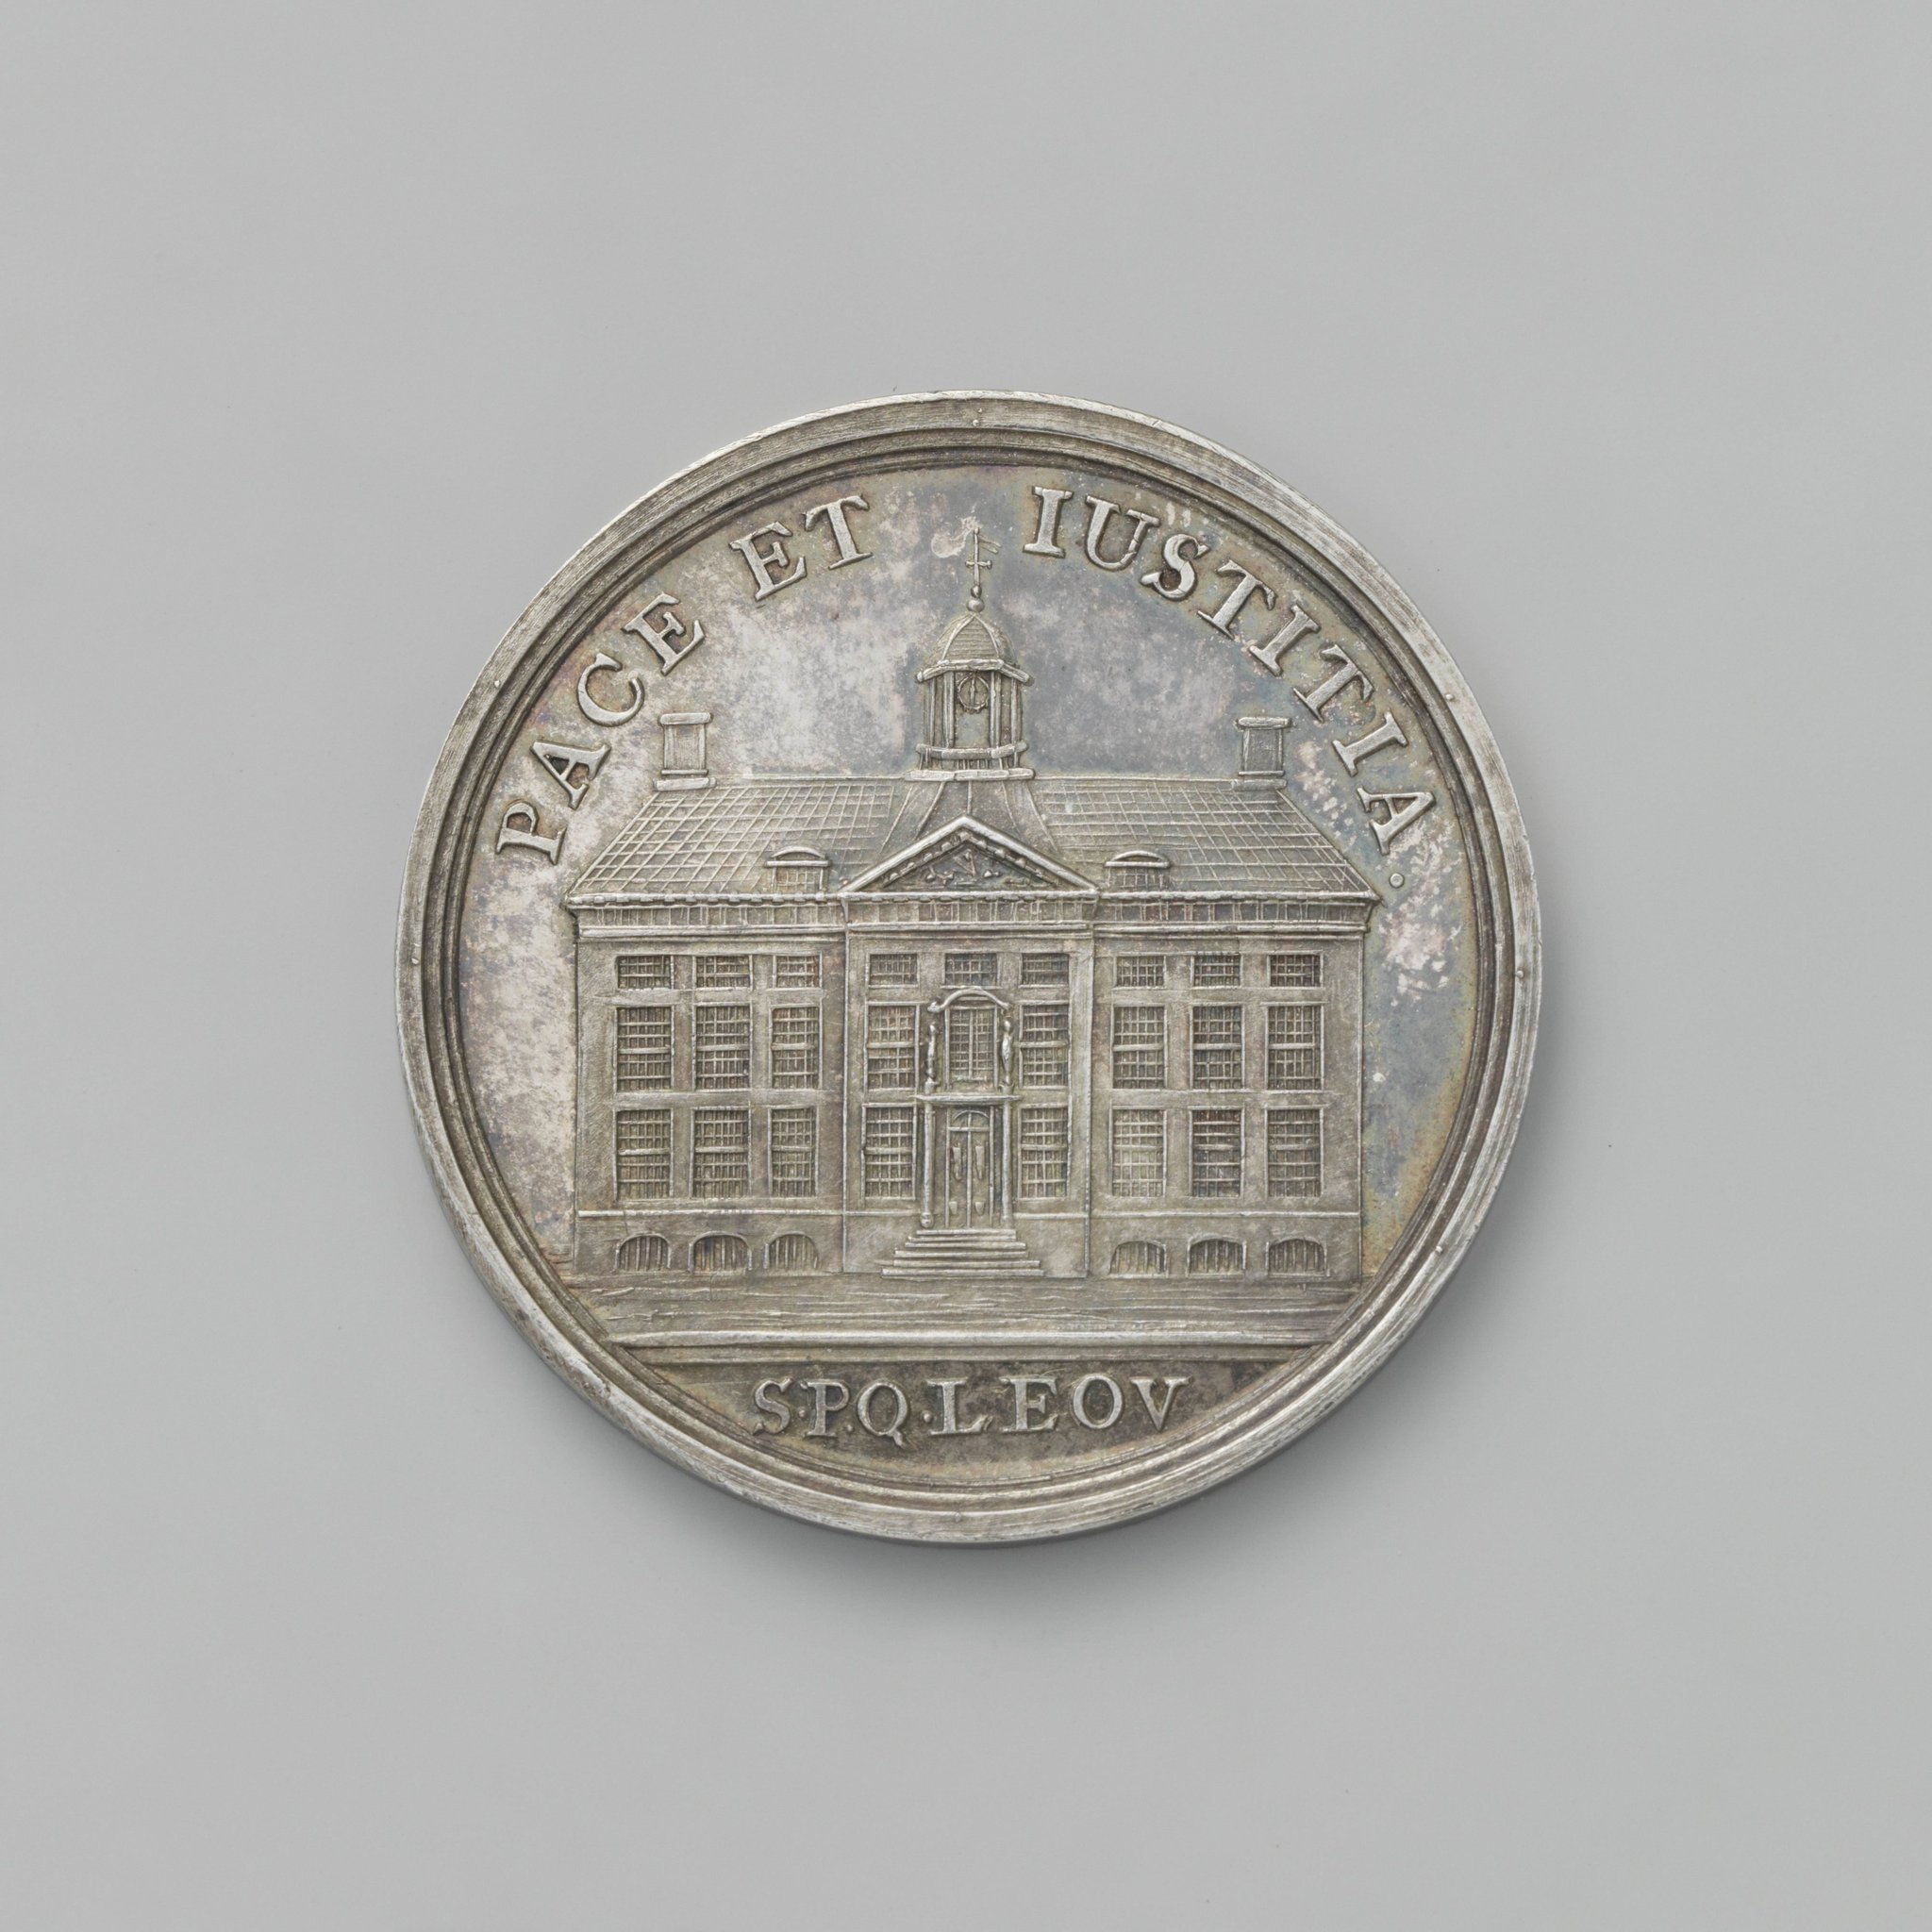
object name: council medal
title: Electiepenning van de stad Leeuwarden, penning voor de leden van de Vroedschap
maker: johan george holtzhey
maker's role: mintmaster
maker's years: 1726-1808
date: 1774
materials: silver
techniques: striking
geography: amsterdam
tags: leeuwarden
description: Zilveren penning. Voorzijde: stadhuis binnen omschrift; afsnede: opschrift. Keerzijde: gezicht op stad vanaf zuidzijde onder gekroond wapenschild, waaruit stralen schieten, rustend op hoorn van overvloed, vaandel, piek en palmtakken.